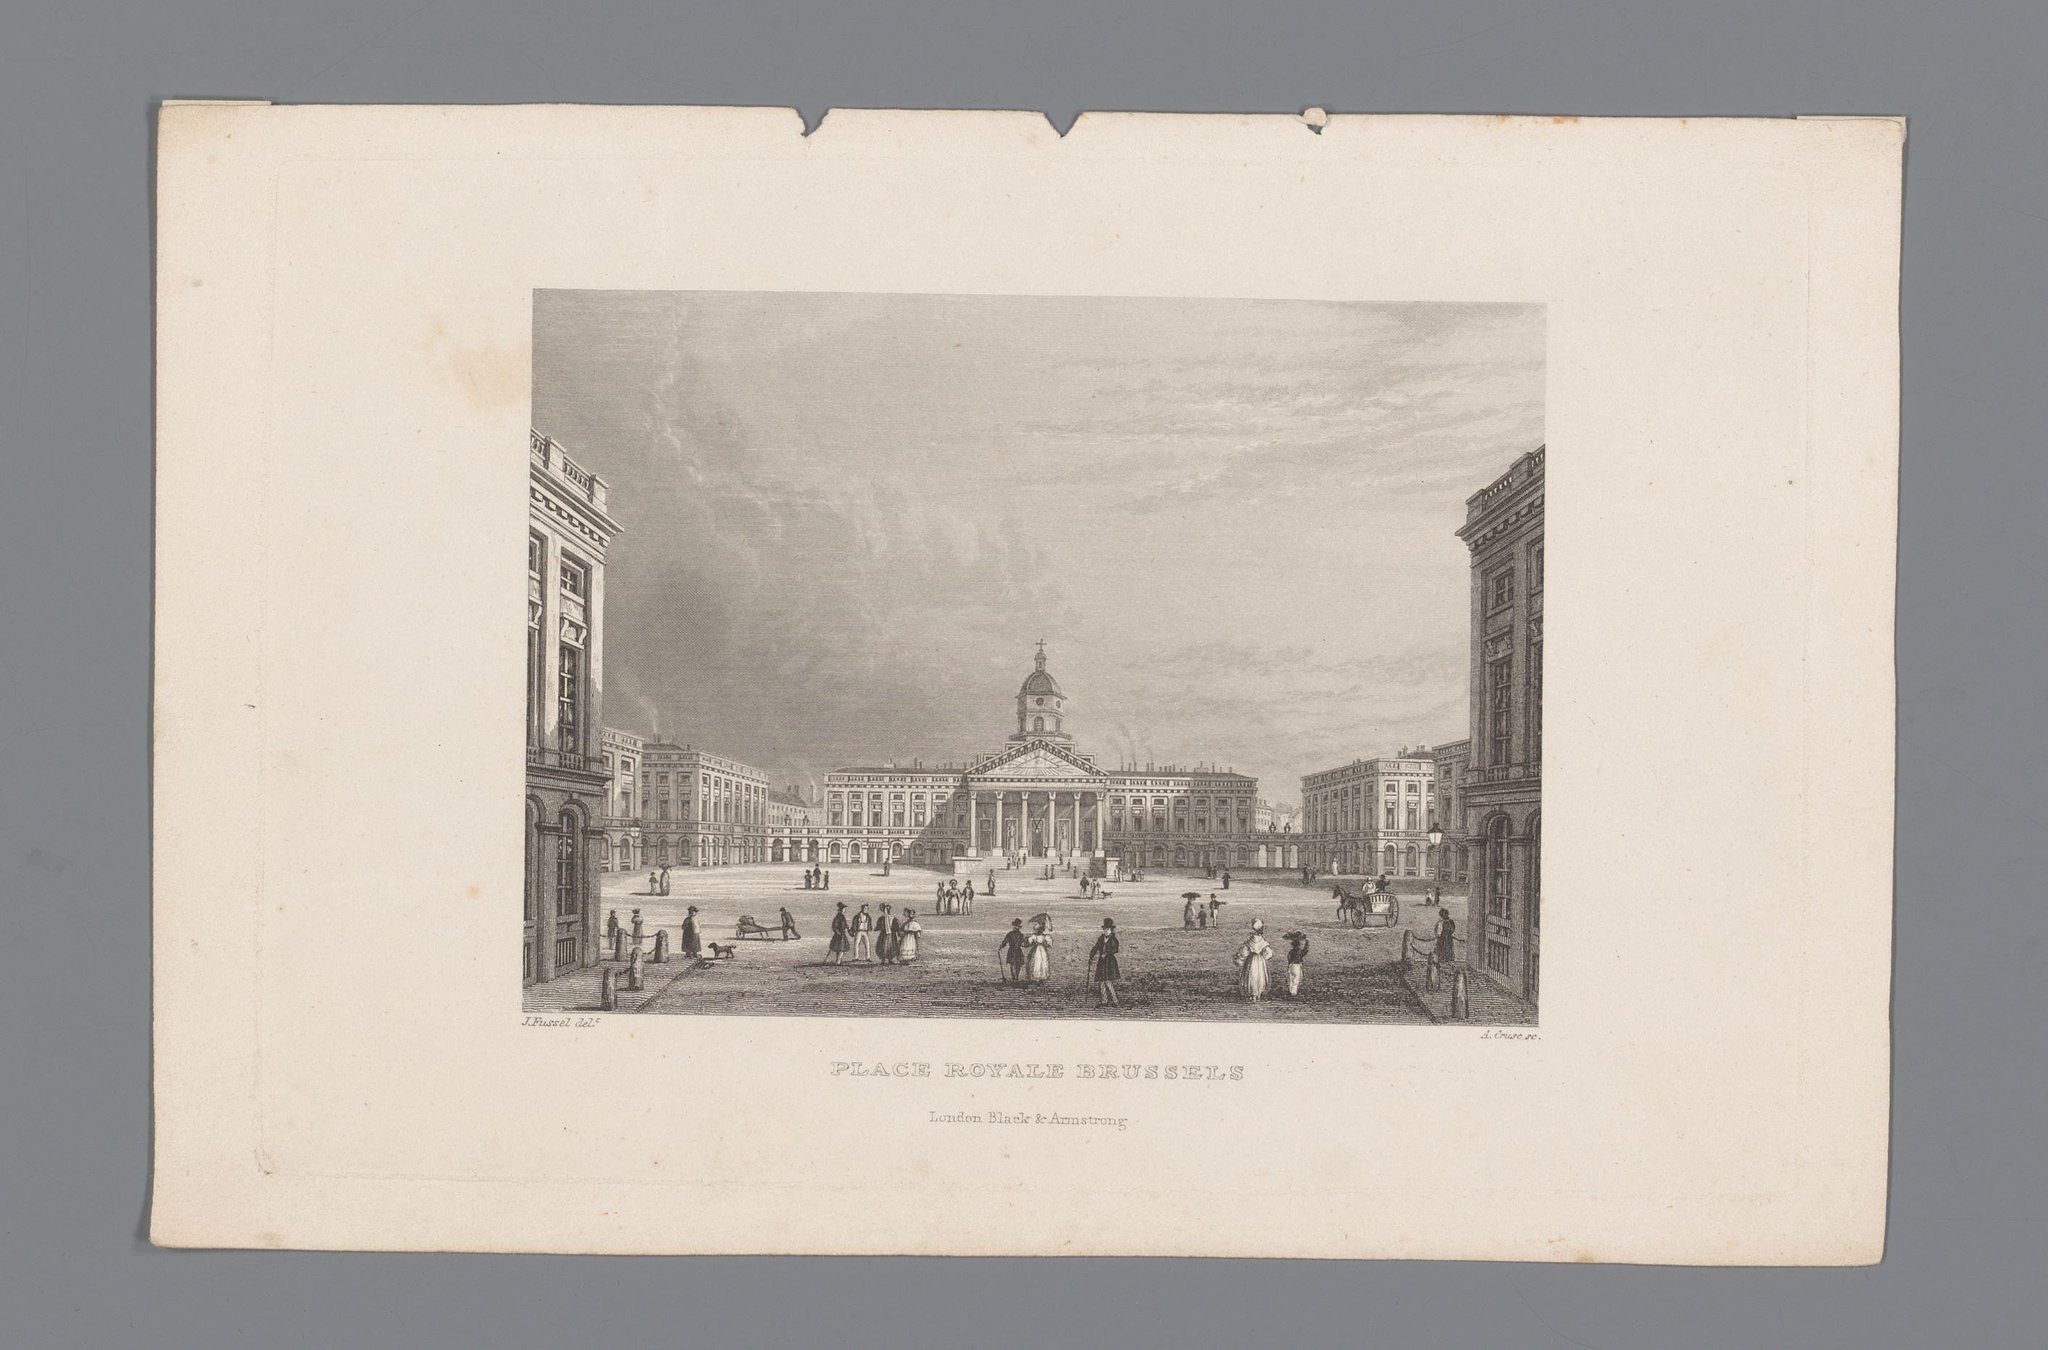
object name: print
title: Place royale Brussels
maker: archelaus cruse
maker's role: print maker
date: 1800-1875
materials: paper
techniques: engraving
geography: london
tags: city-view, and landscape with man-made constructions, hôtel, i.e. small palace in city, brussels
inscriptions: collector's mark: Lugt 2233